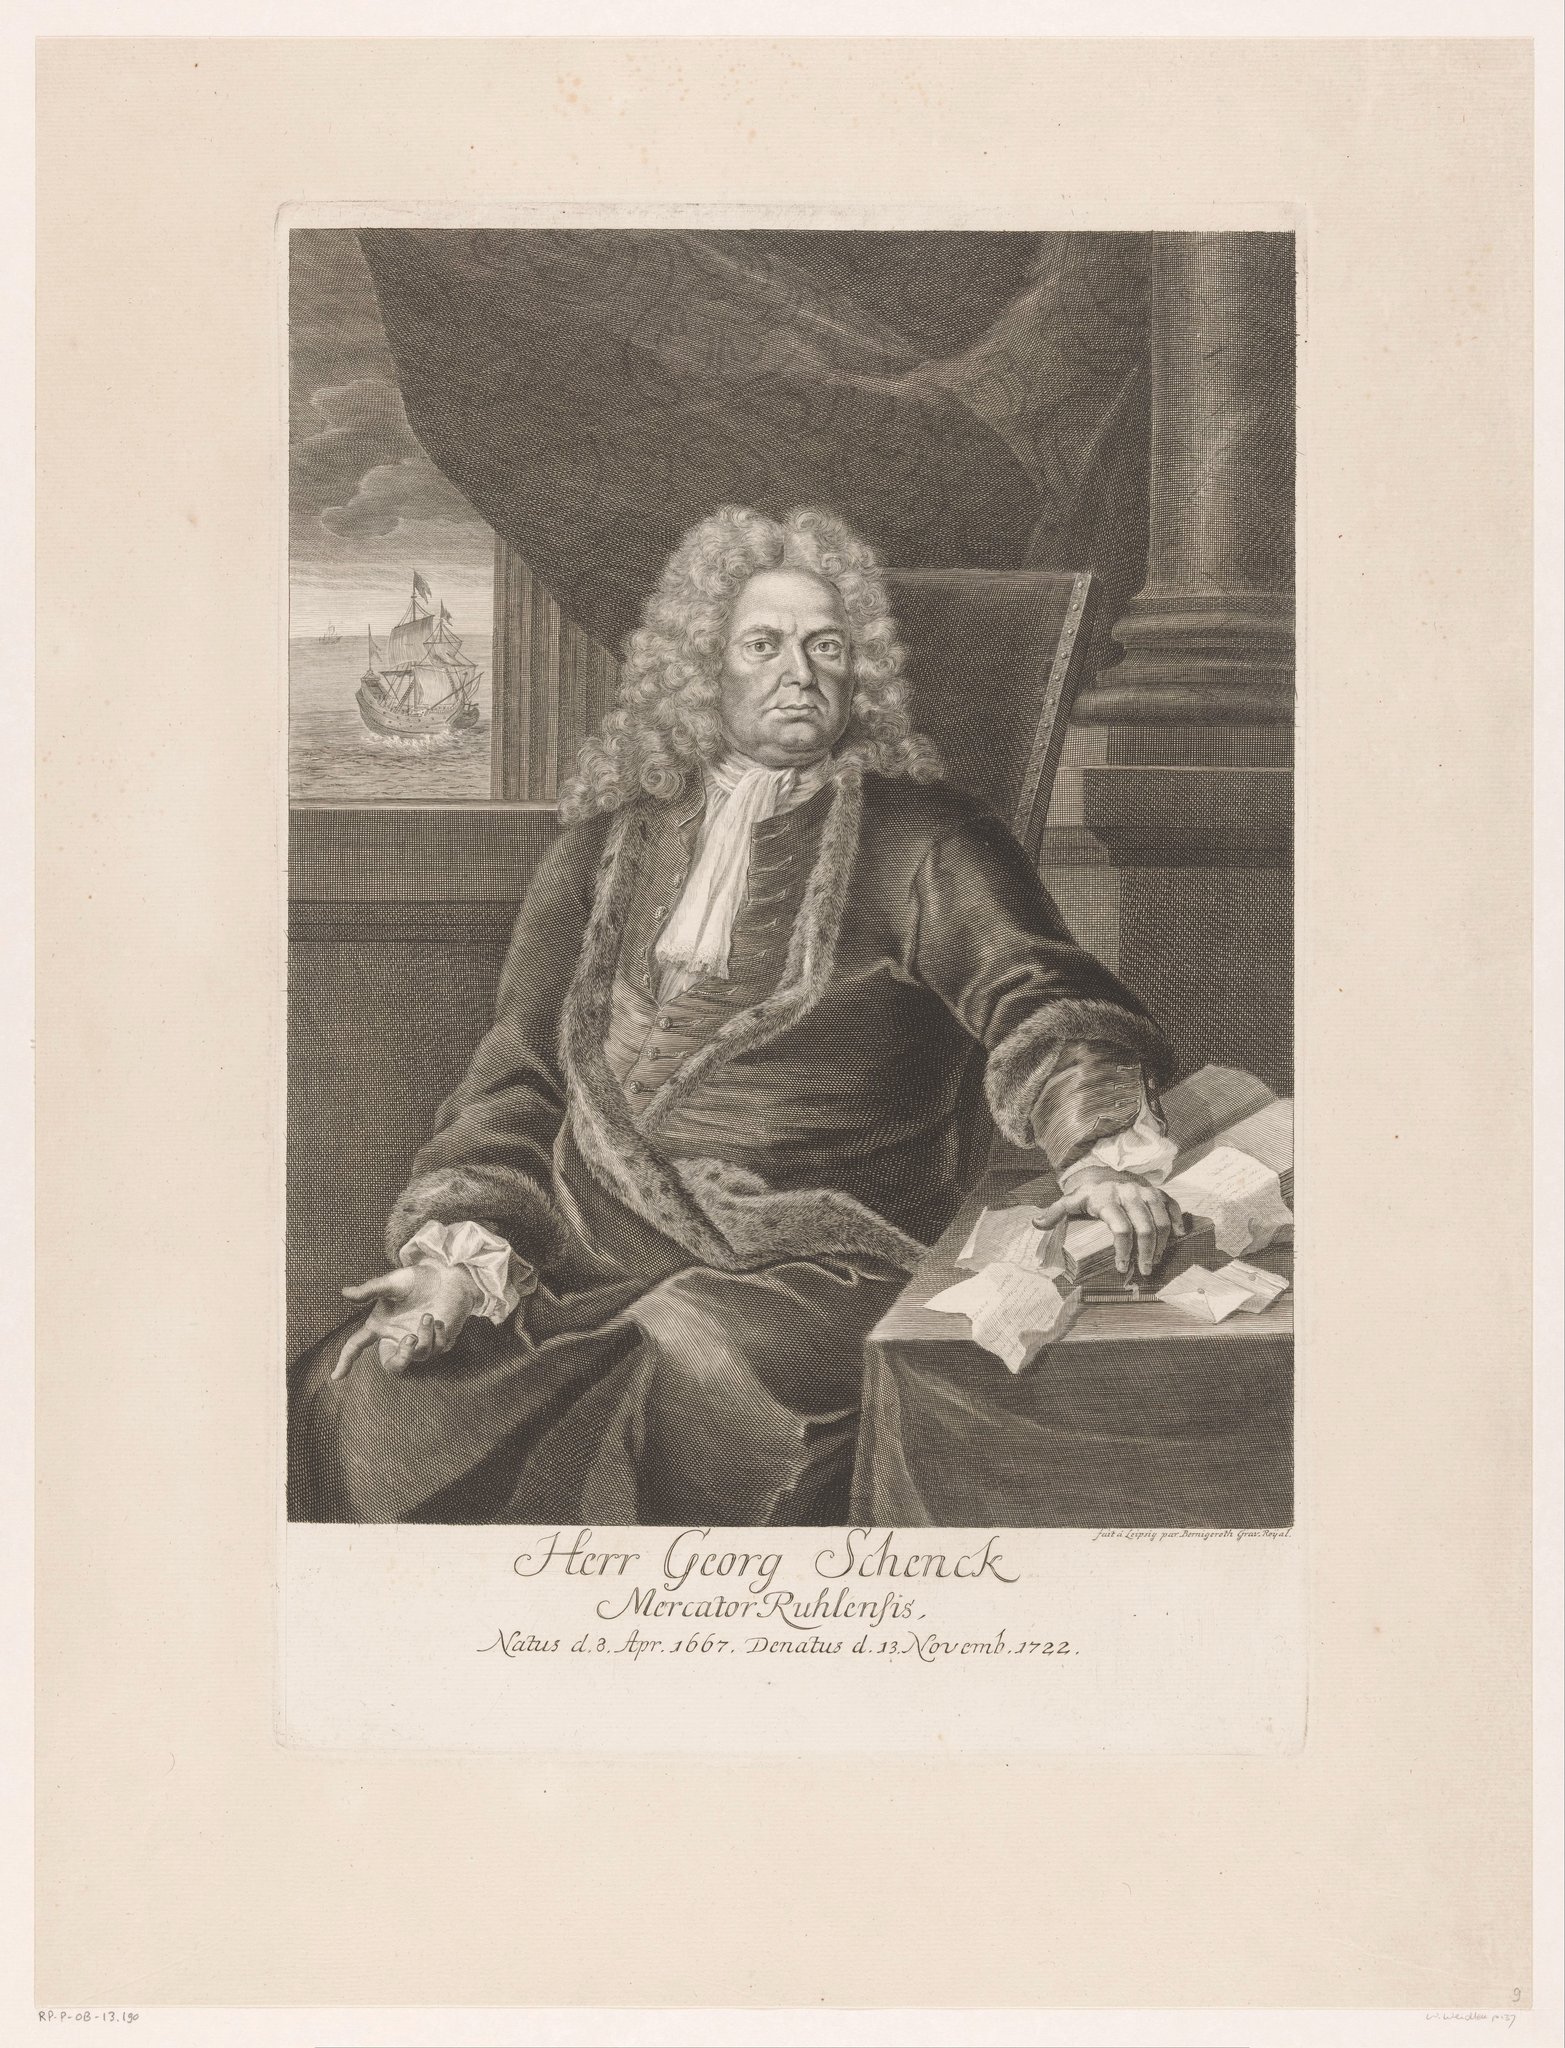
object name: print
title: Portret van Georg Schenck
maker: martin bernigeroth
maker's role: print maker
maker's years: 1670-1733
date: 1722-1733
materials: paper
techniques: engraving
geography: leipzig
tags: sailing-ship, sailing-boat, historical persons, letter, envelope